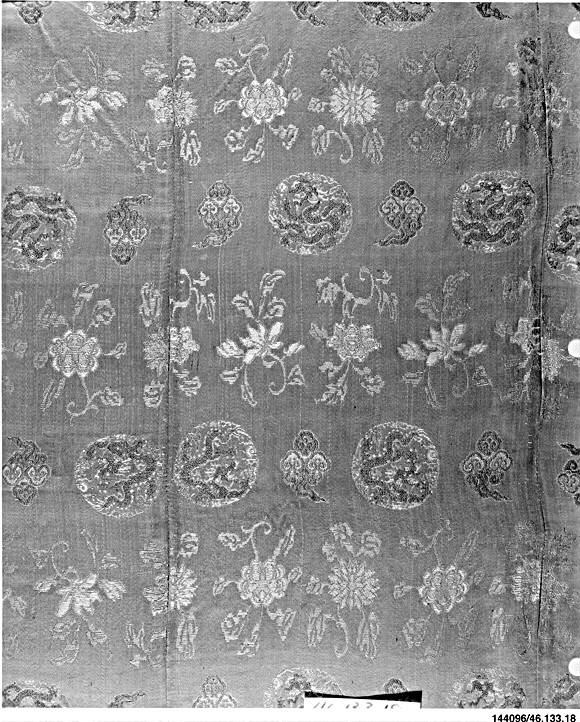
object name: piece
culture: chinese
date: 1601-1800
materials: metal thread, silk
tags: dragons,leaves